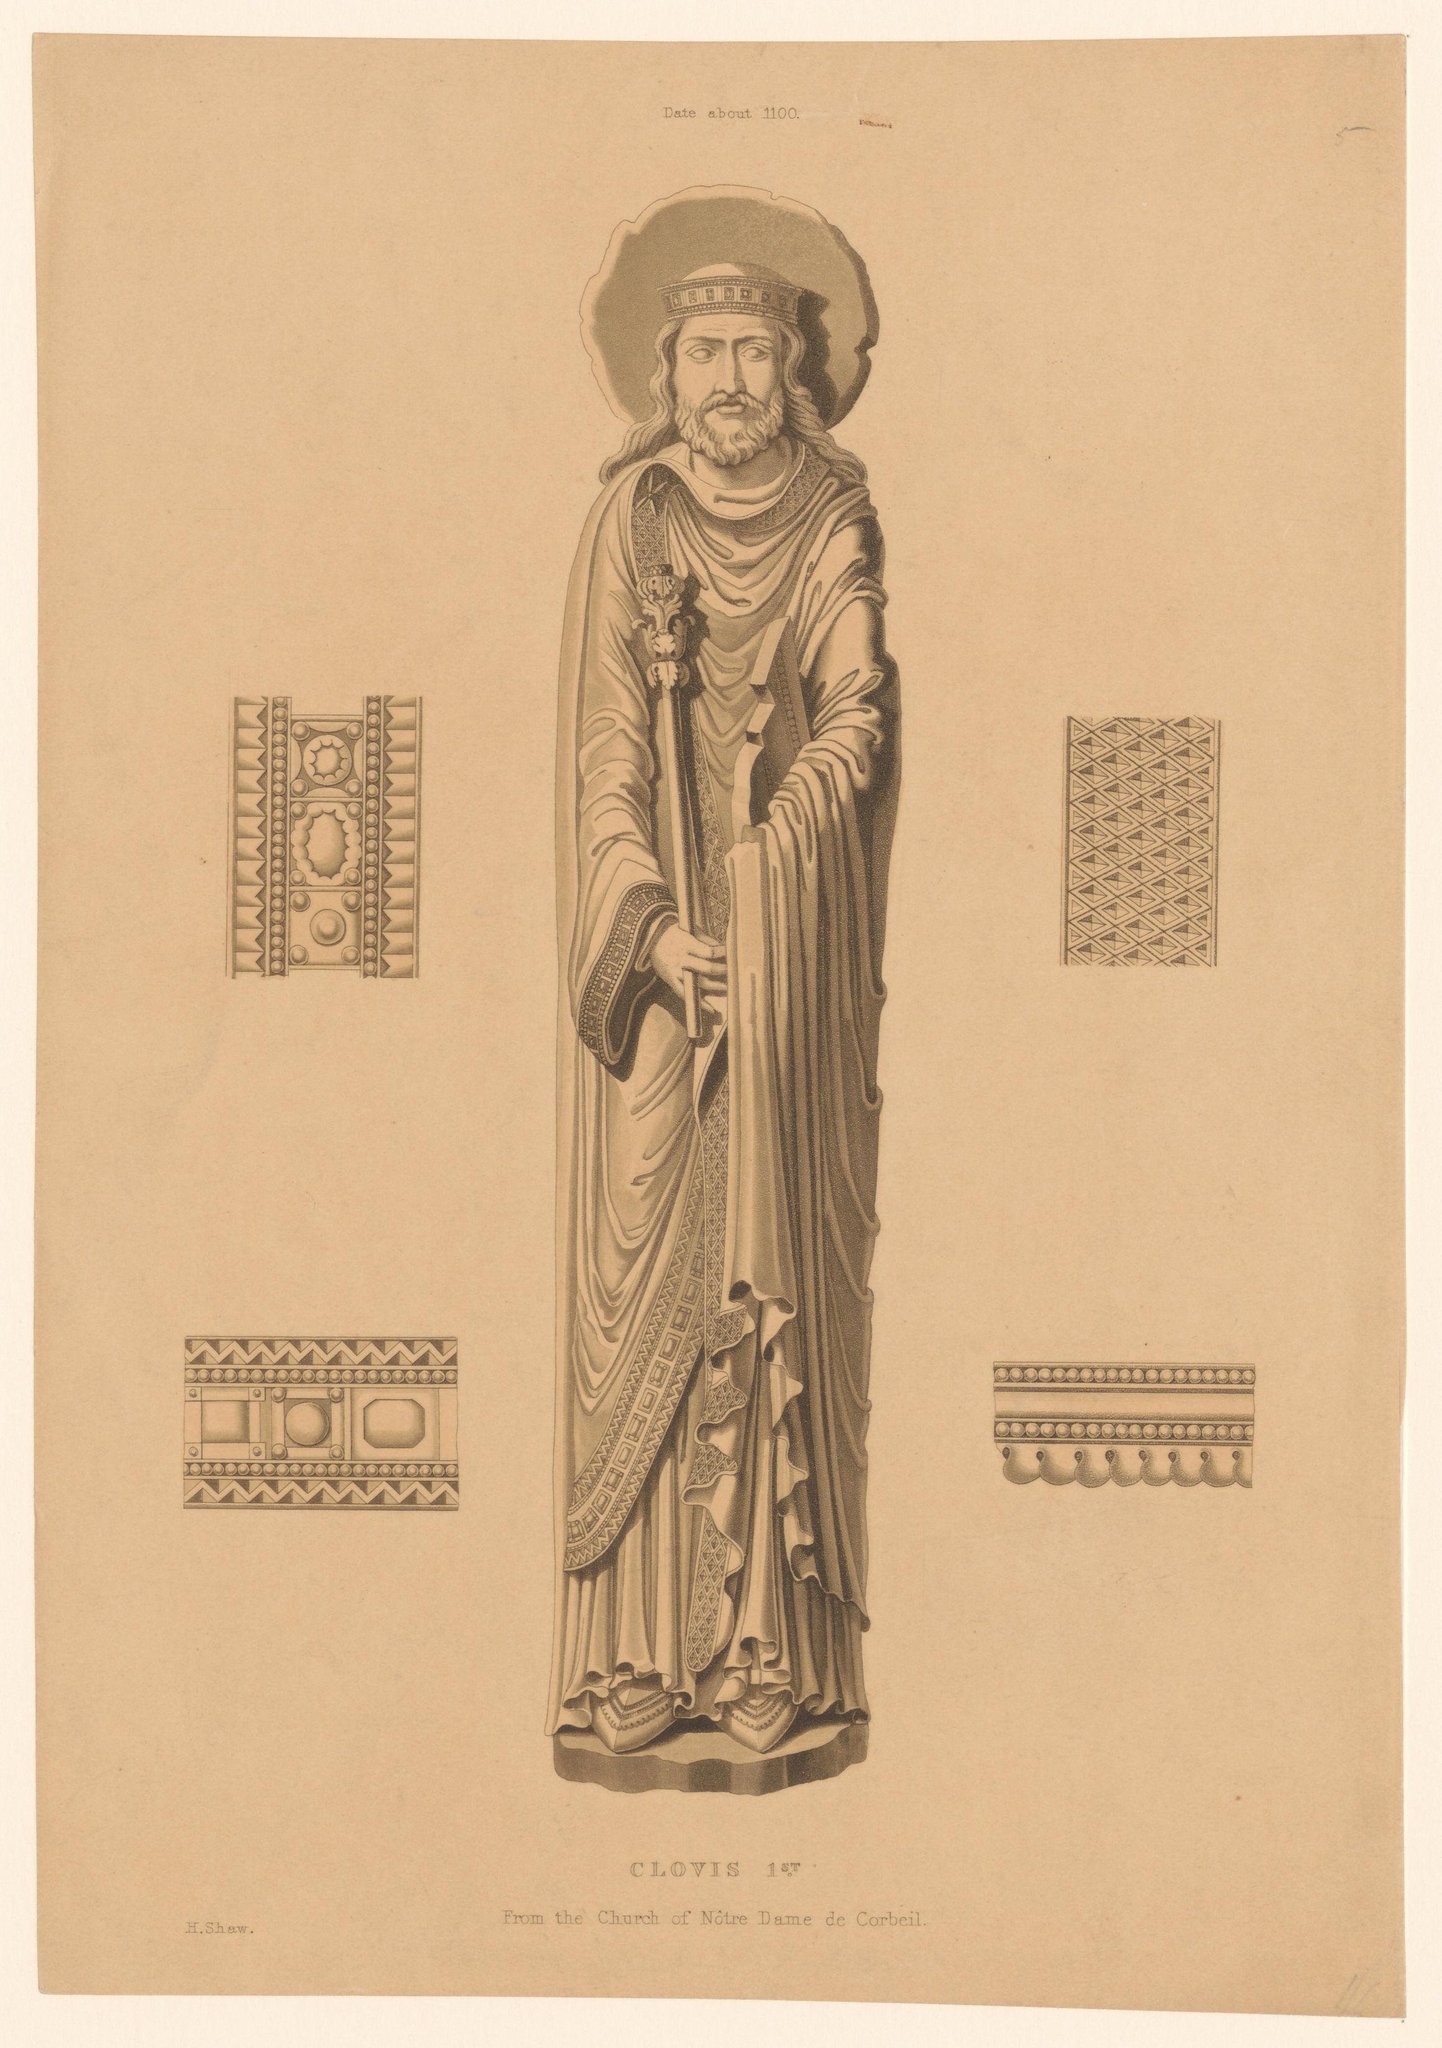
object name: print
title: Beeld van Clovis I, koning van de Franken en architecturale ornamenten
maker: henry shaw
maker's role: print maker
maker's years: 1800-1873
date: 1810-1873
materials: paper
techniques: aquatint, etching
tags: paris, sculpture, ornament derived from architectural details, king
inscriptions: collector's mark: Lugt 2228